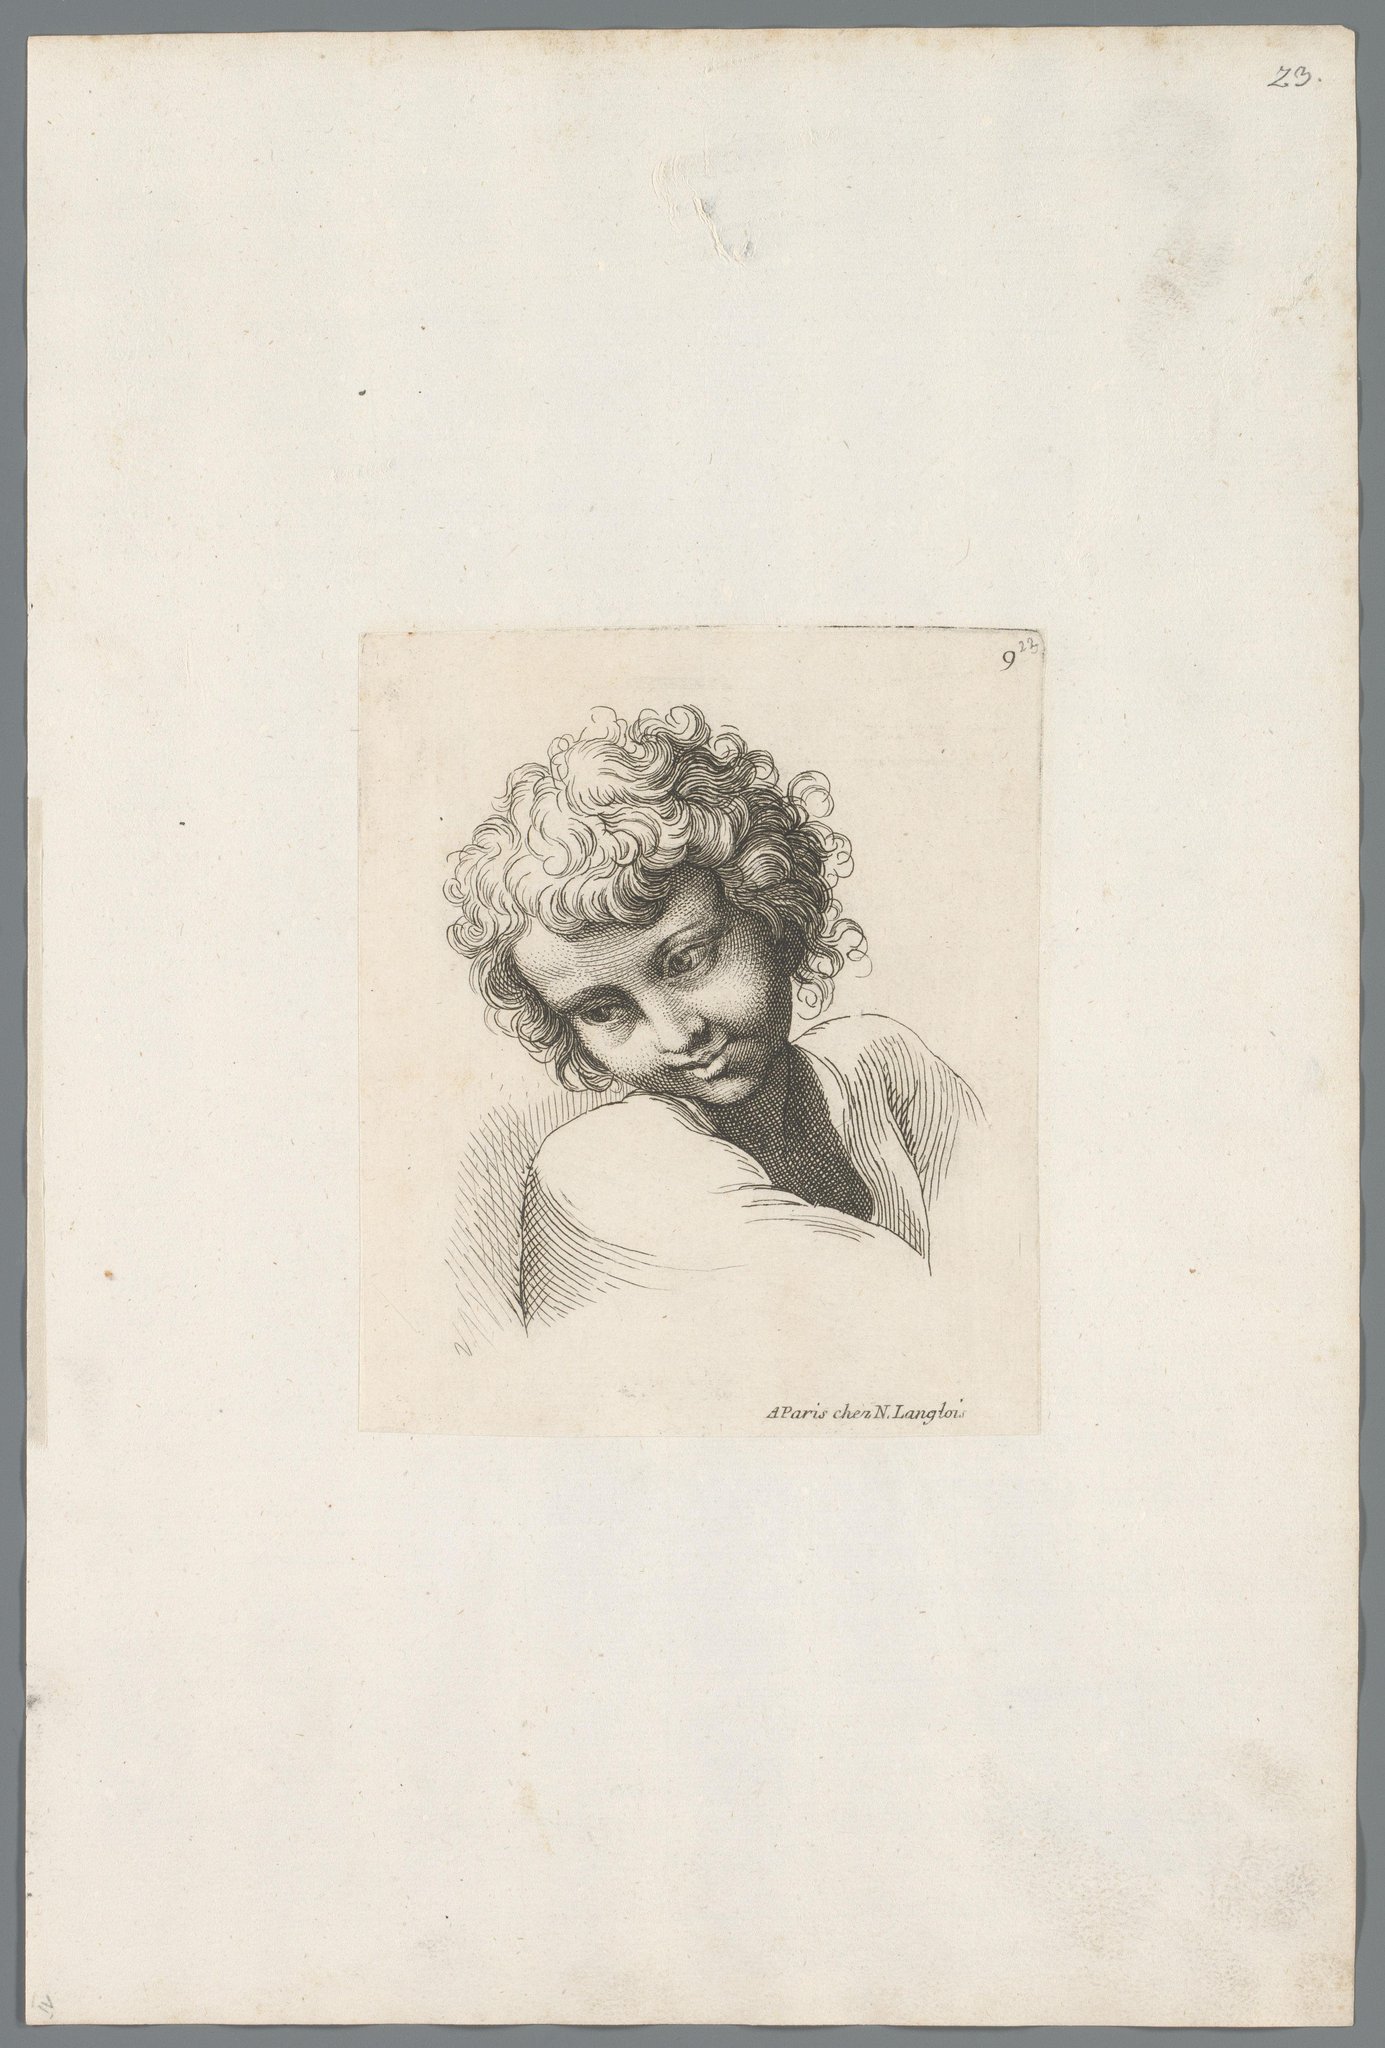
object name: print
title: Hoofd van een jongen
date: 1650-1703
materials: paper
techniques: etching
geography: paris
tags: face, boy (child between toddler and youth)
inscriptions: collector's mark: Lugt 2228, collector's mark: Lugt 2760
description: Prent uit een serie met op elke prent een hoofd uit een schilderij van Poussin.